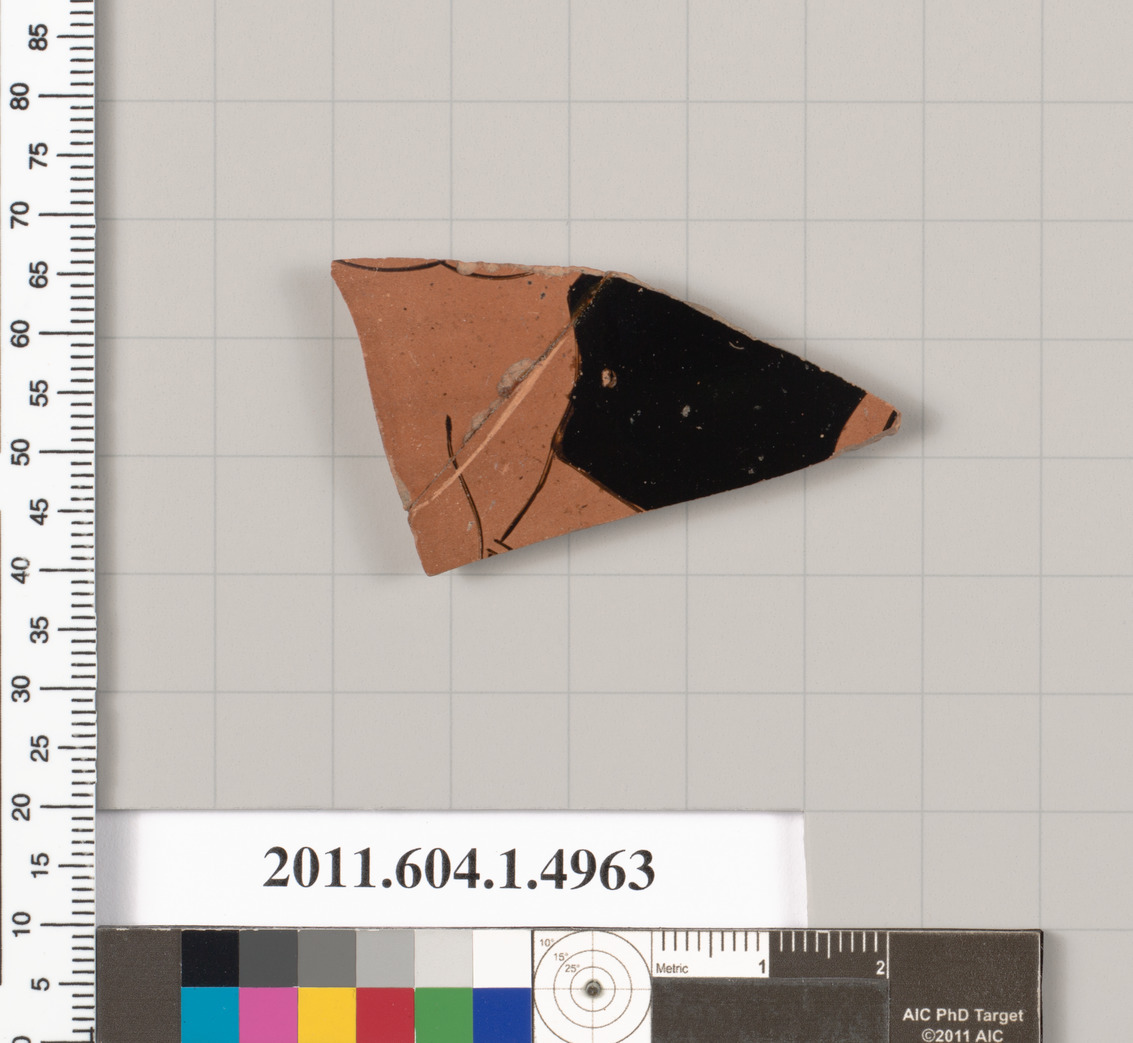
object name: kylix fragment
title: Terracotta fragment of a kylix (drinking cup)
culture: greek, attic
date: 520-490 BCE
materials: terracotta